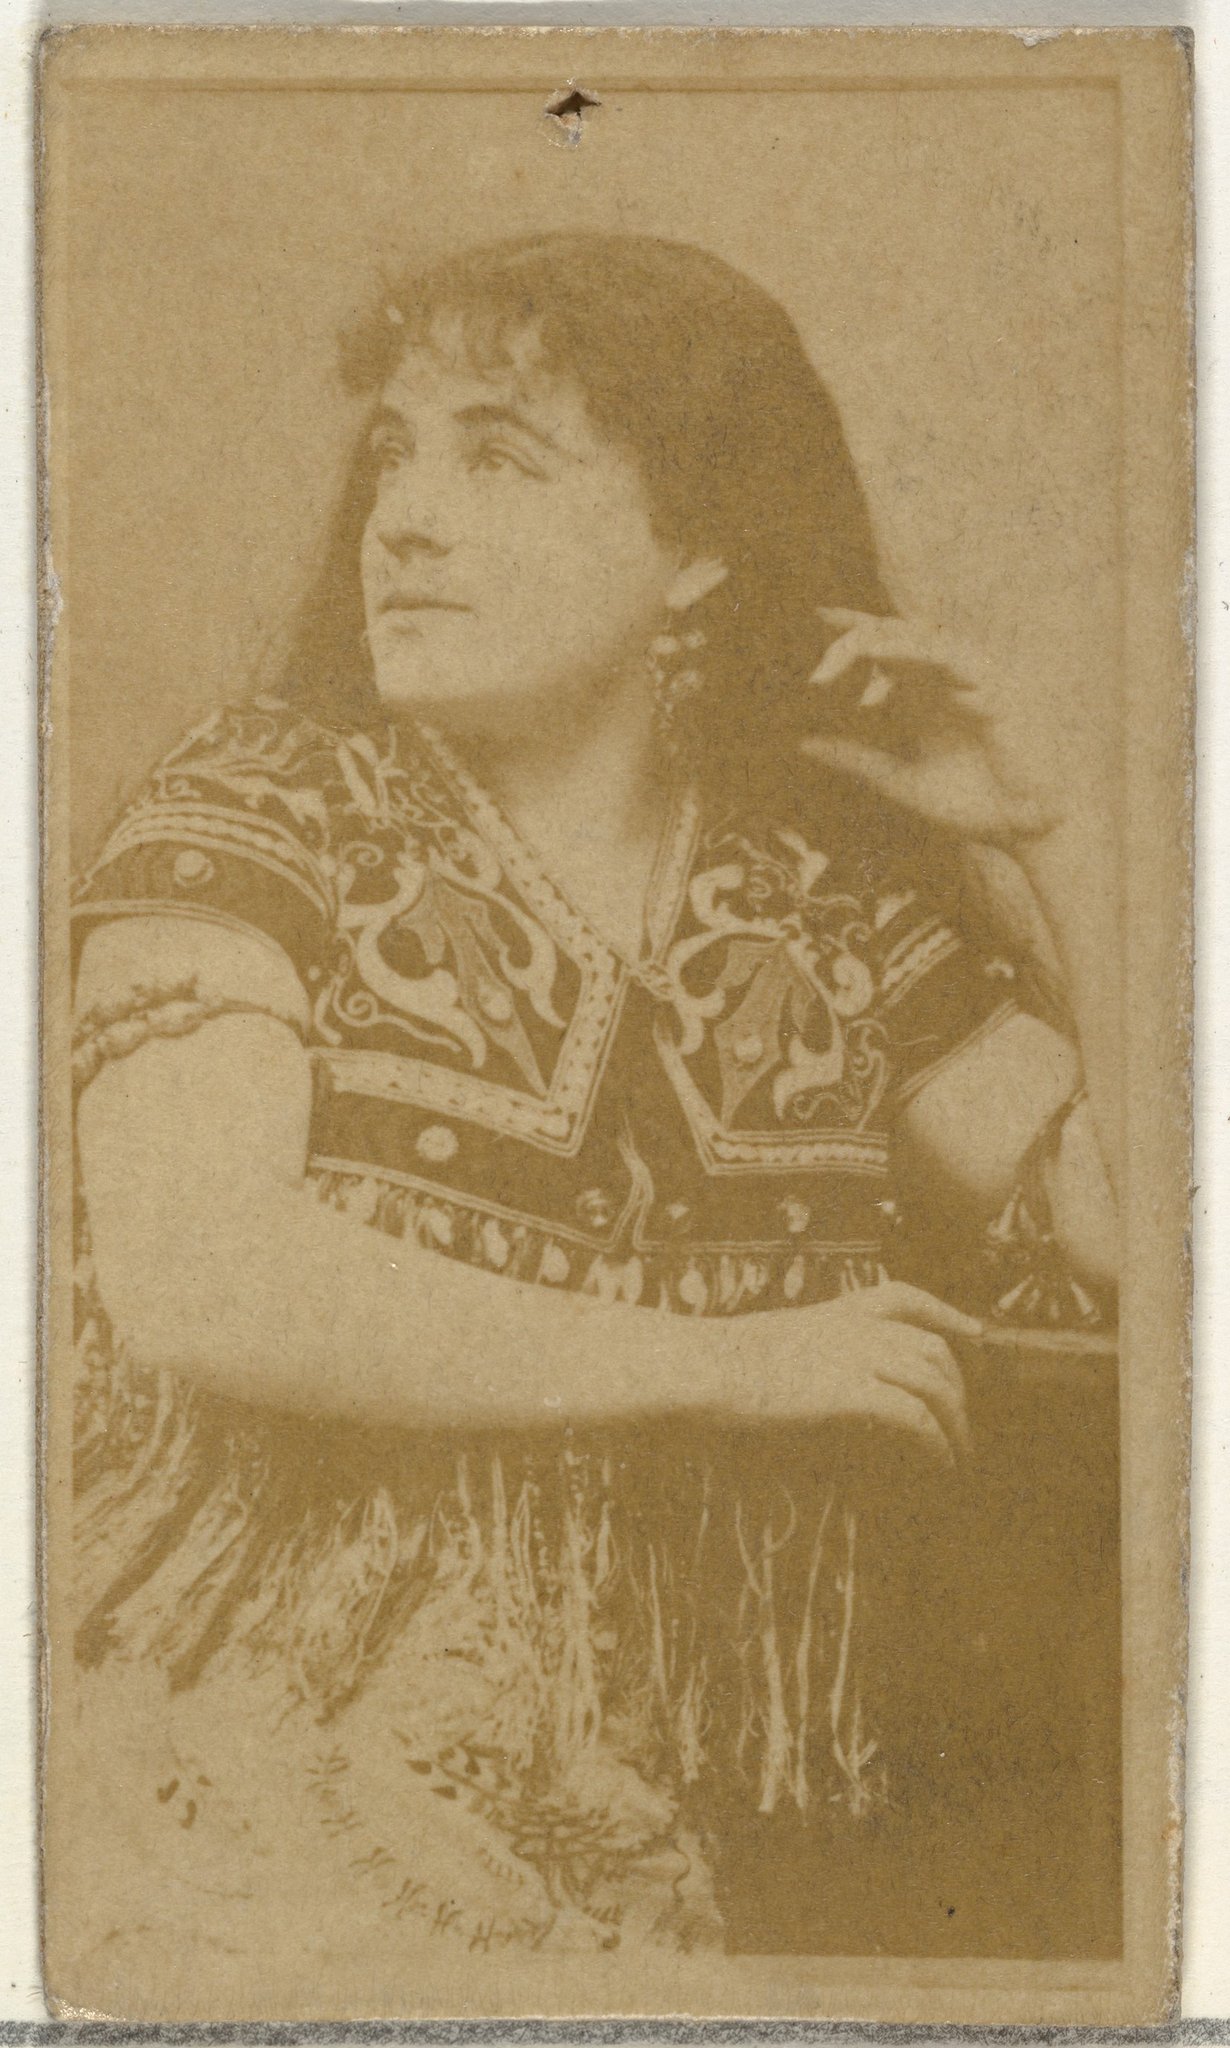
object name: photograph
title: [Actress wearing patterned bodice], from the Actors and Actresses series (N145-8) issued by Duke Sons & Co. to promote Duke Cigarettes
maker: w. duke, sons & co.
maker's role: publisher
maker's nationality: american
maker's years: 1870-1920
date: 1891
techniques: albumen silver print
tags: portraits,women,actresses